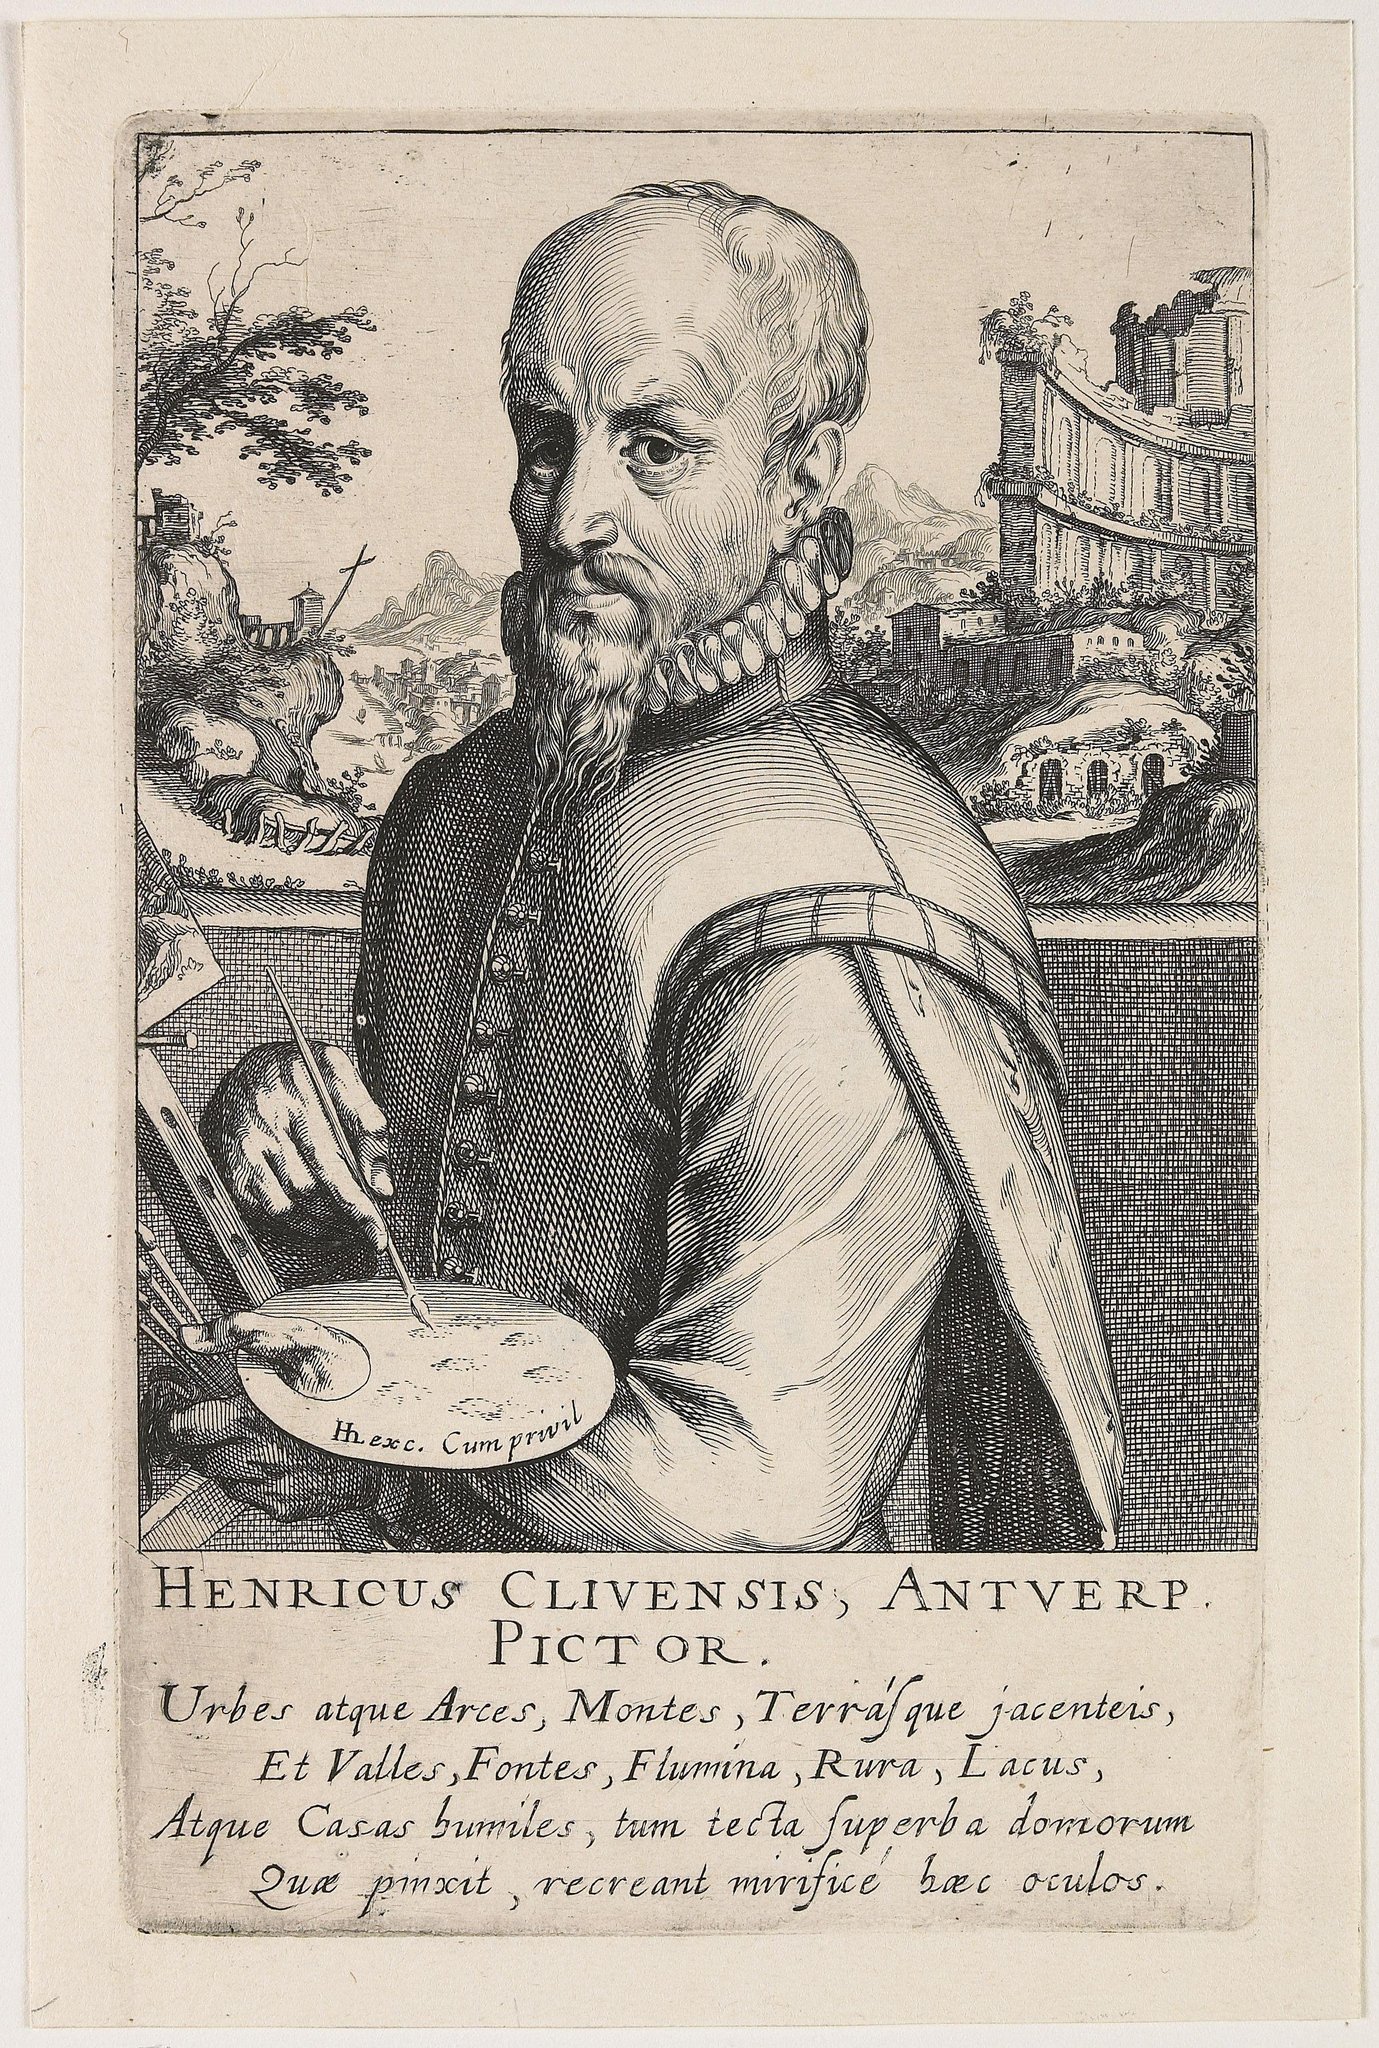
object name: print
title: Portret van Hendrik van Cleef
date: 1610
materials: paper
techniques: engraving, etching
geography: the hague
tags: print maker, draughtsman, hendrick van cleve, portrait, self-portrait of artist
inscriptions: collector's mark: Lugt 2228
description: De prent is gebruikt als illustratie in: Effigies Pictorum aliquot celebrium praecipué Germaniae inferioris, Den Haag: Henricus Hondius, 1610(?). De 24 portretten gemaakt door Frisius maken deel uit van een 72-delige portretserie.